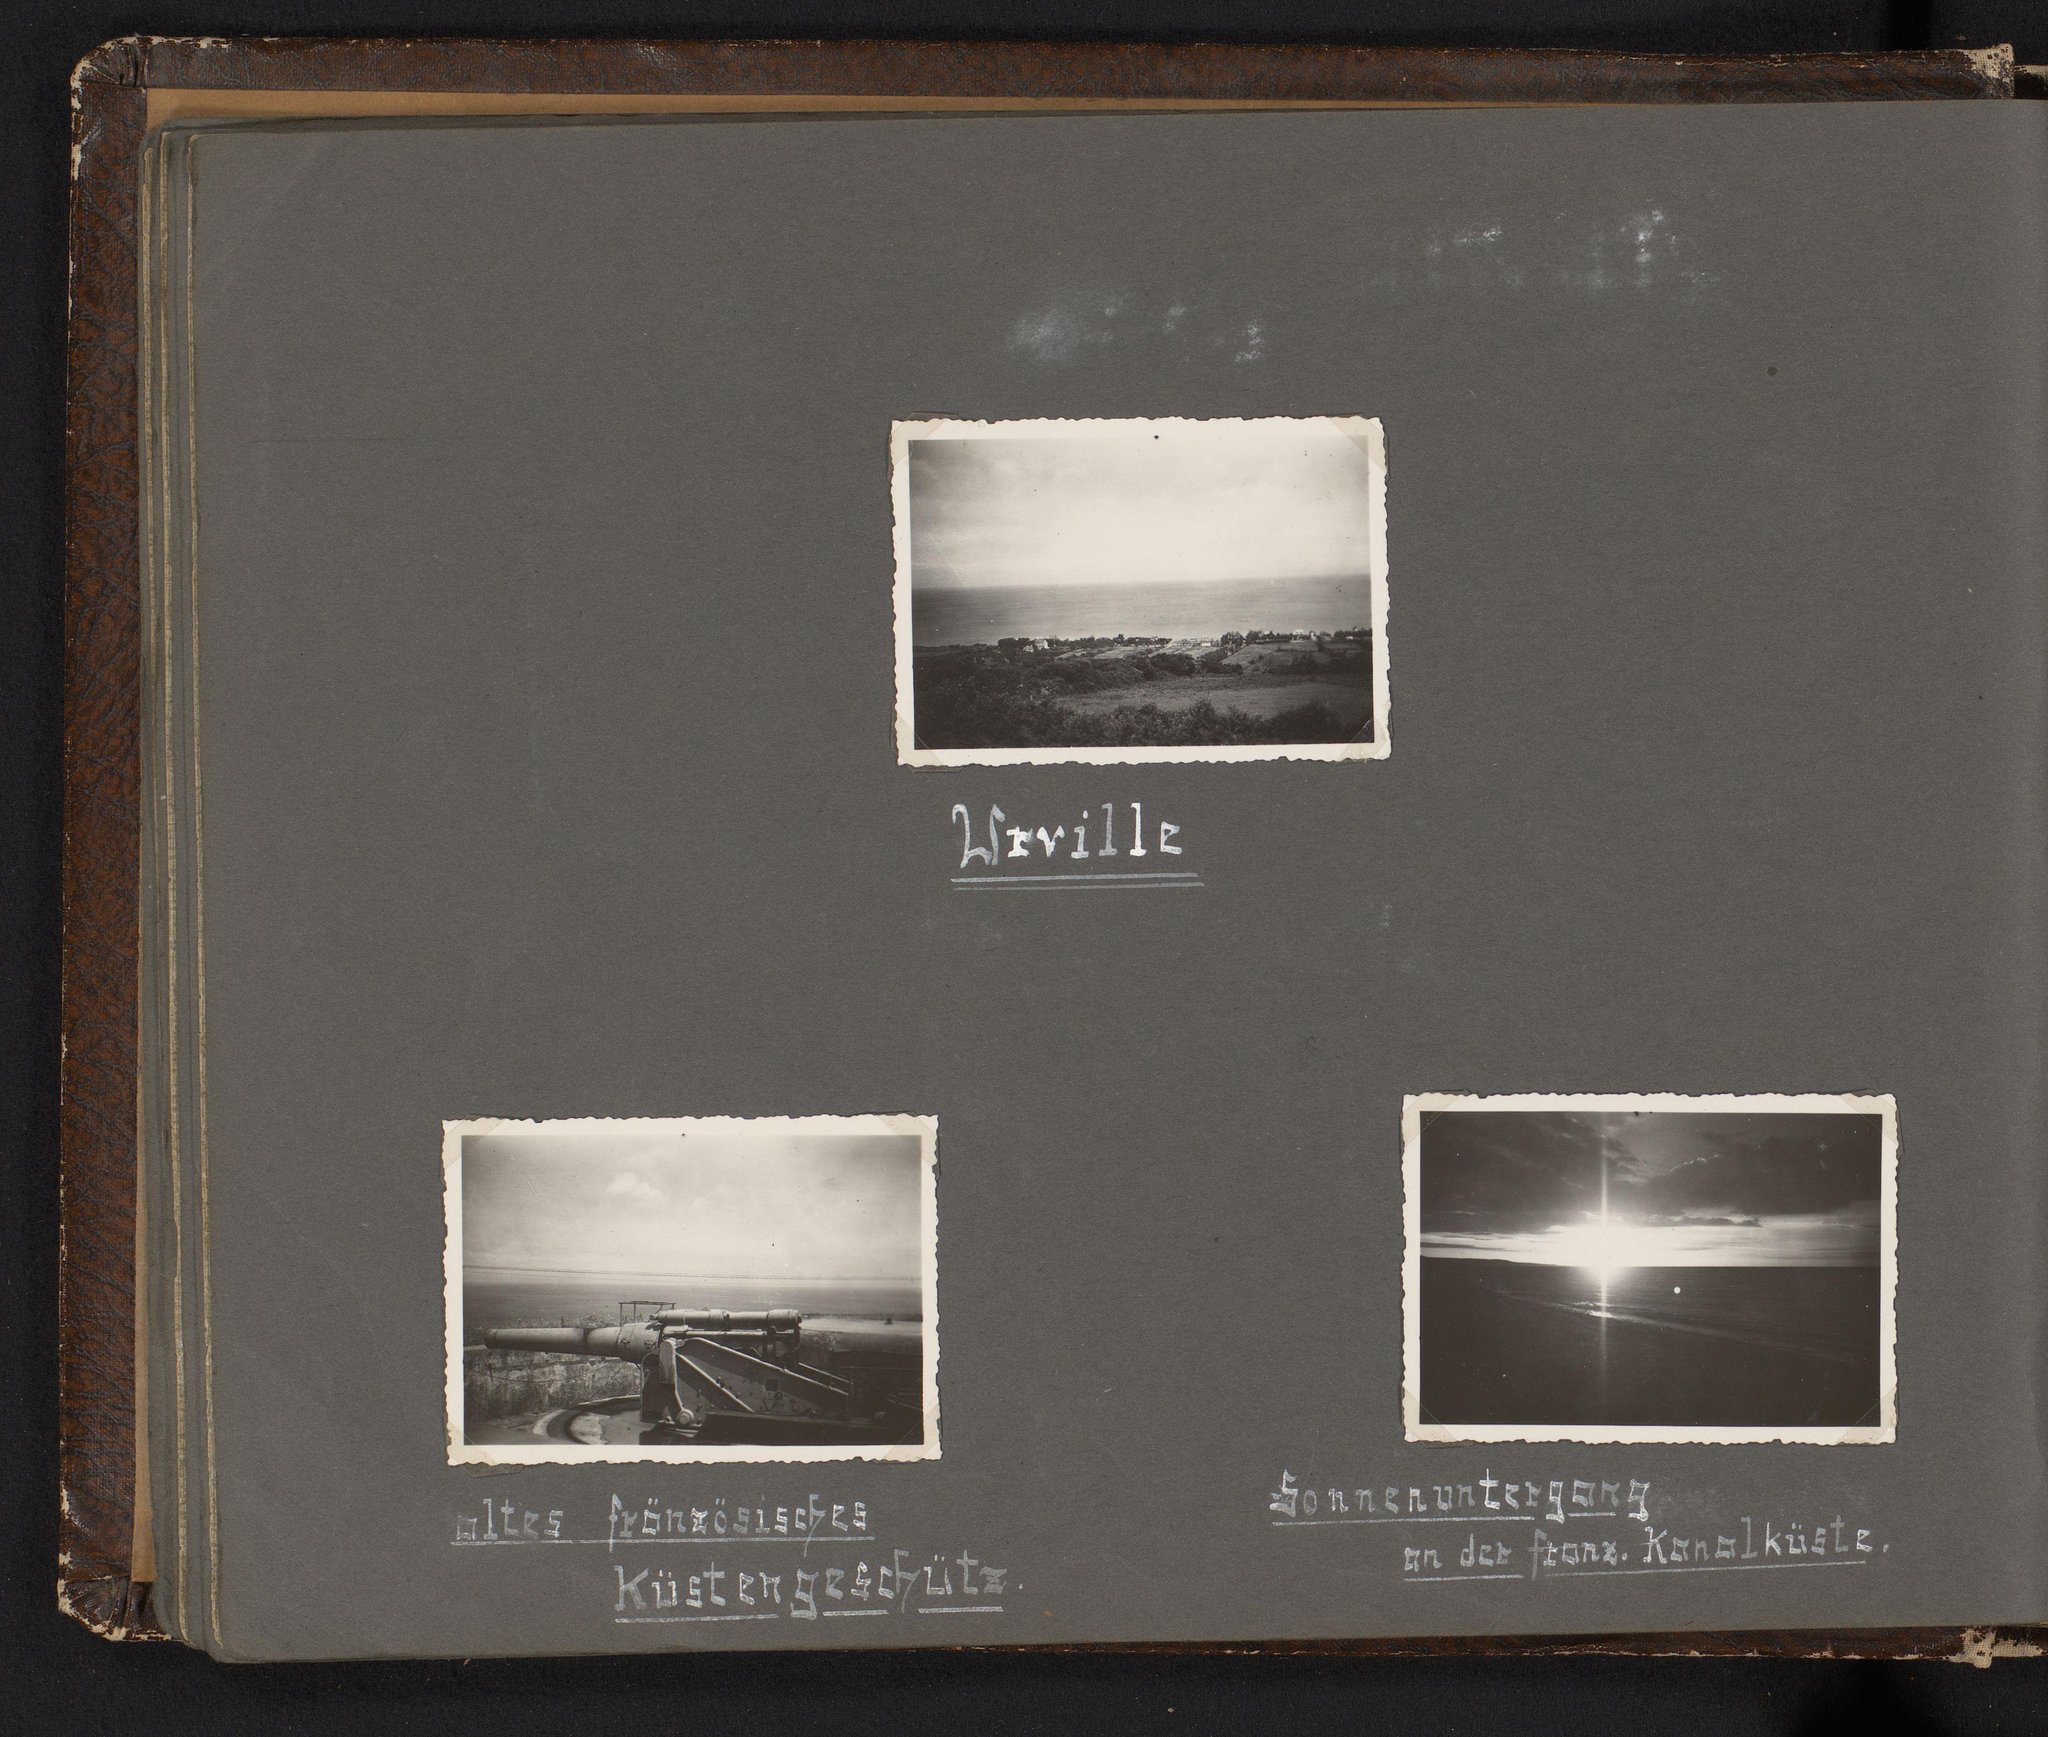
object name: album leaf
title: Kriegsmarine in Urville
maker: Anonymous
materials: paper, photographic support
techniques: gelatin silver print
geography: urville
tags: (military) self-protection, sunset, coast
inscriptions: inscription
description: Albumblad met drie foto's van kustlandschappen te Urville, gestationeerd tussen 20 juni en 30 juli 1941. Onderdeel van het fotoalbum Kriegsmarine.